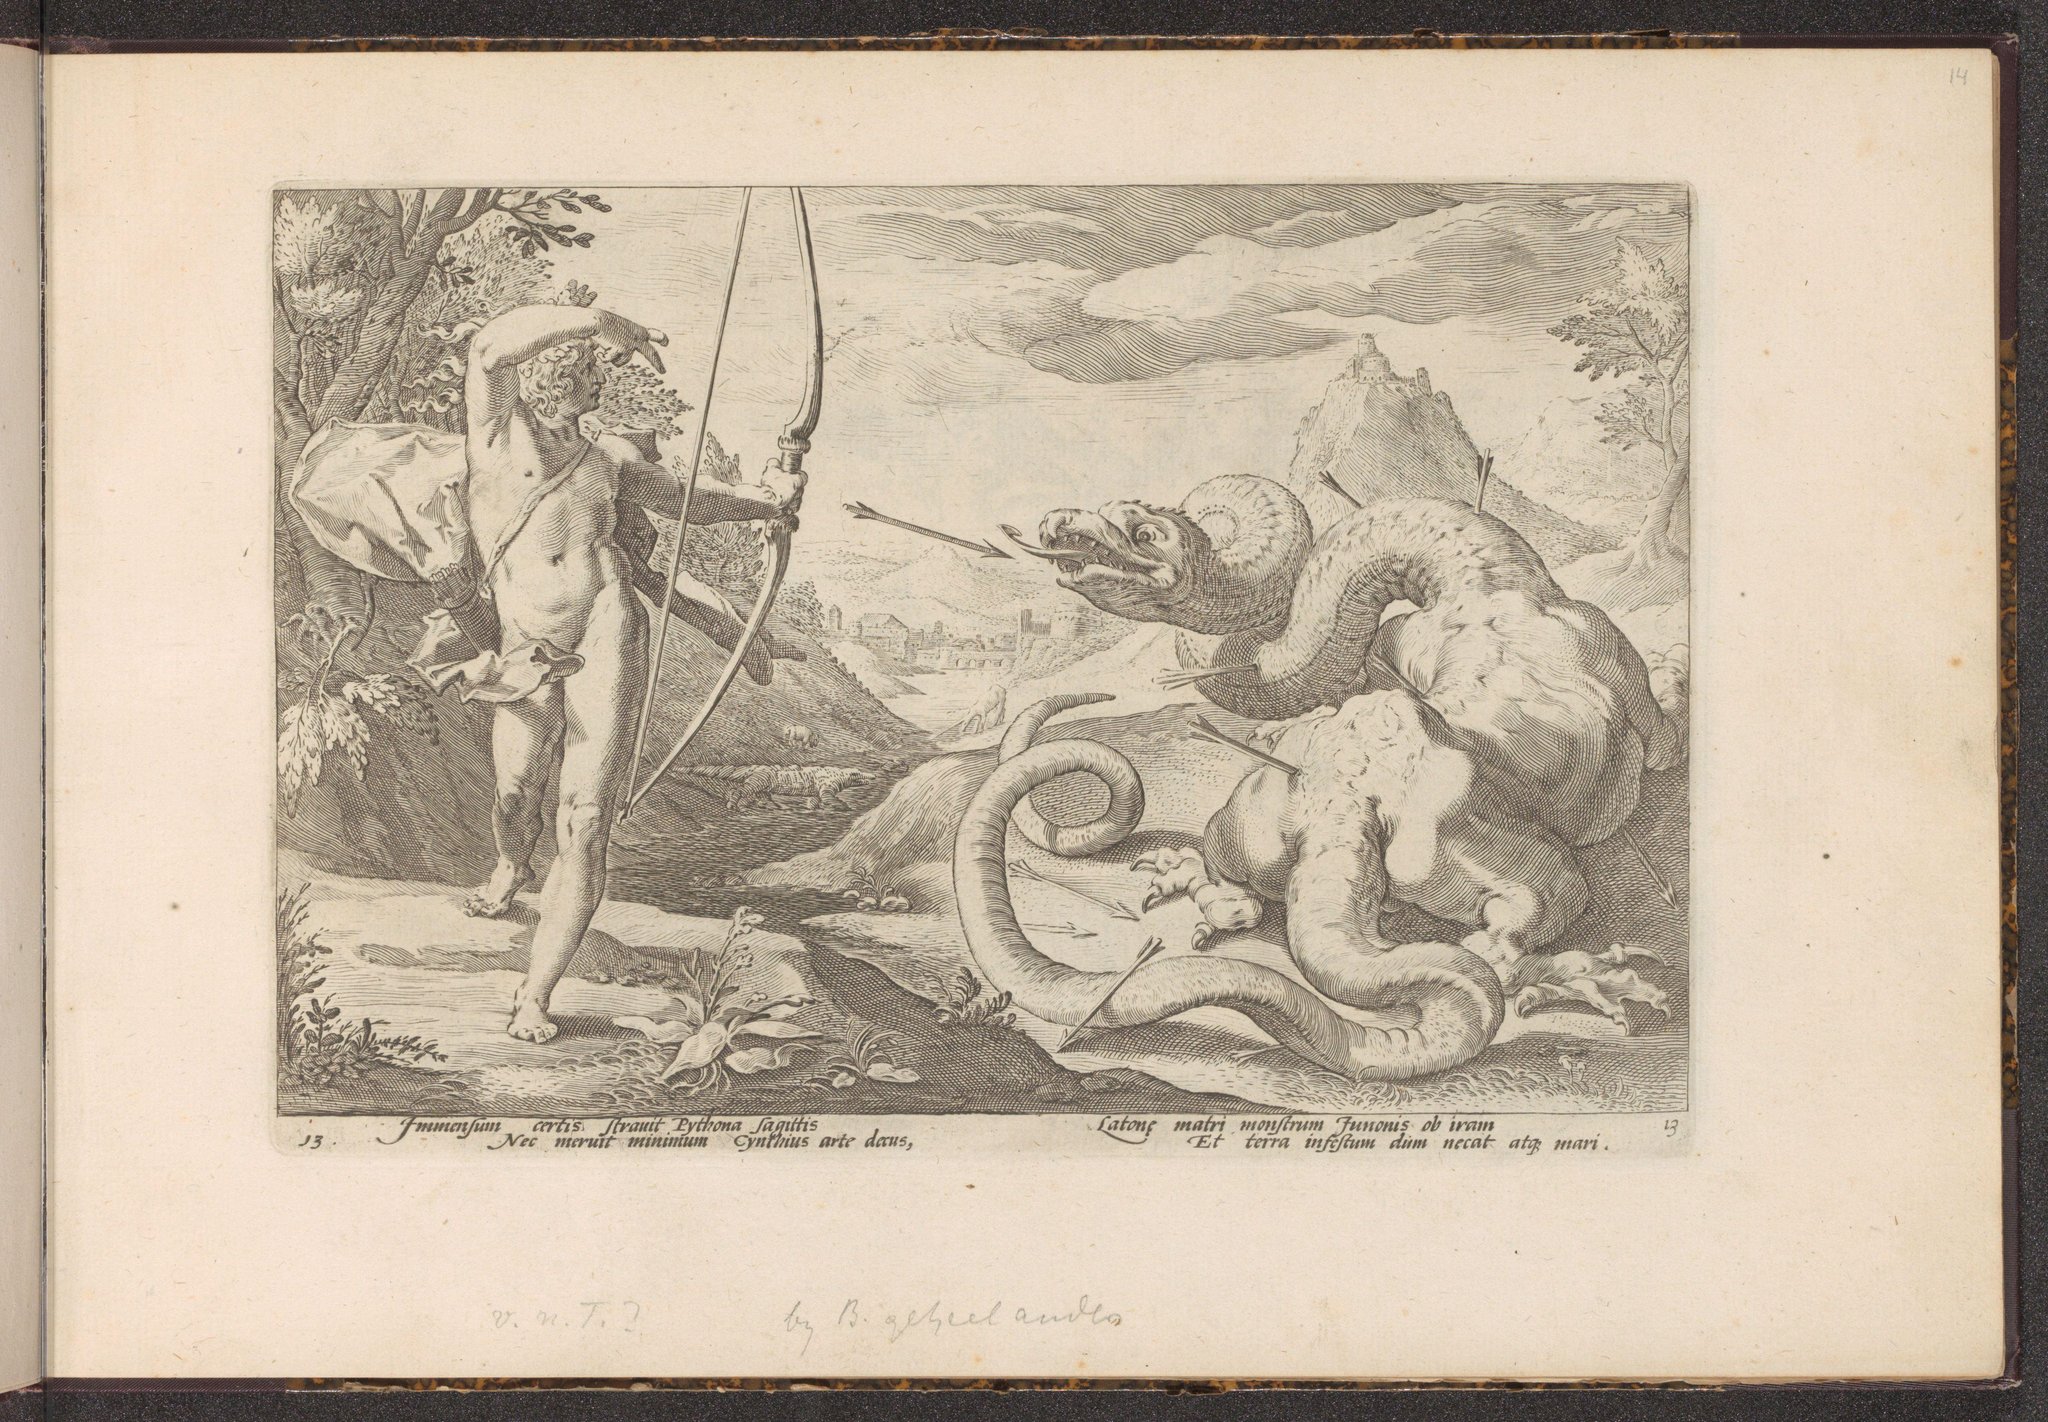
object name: album leaf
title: Apollo doodt de reuzenslang Python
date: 1589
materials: paper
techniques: engraving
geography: haarlem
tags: apollo shoots python, the dragon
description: Apollo doodt met vele pijlen de reuzenslang Python (hier meer als een draak afgebeeld, met poten). Op de achtergrond lopen een krokodil, schaap en hert. Onder de voorstelling twee keer twee versregels in het Latijn. De prent maakt deel uit van een album.